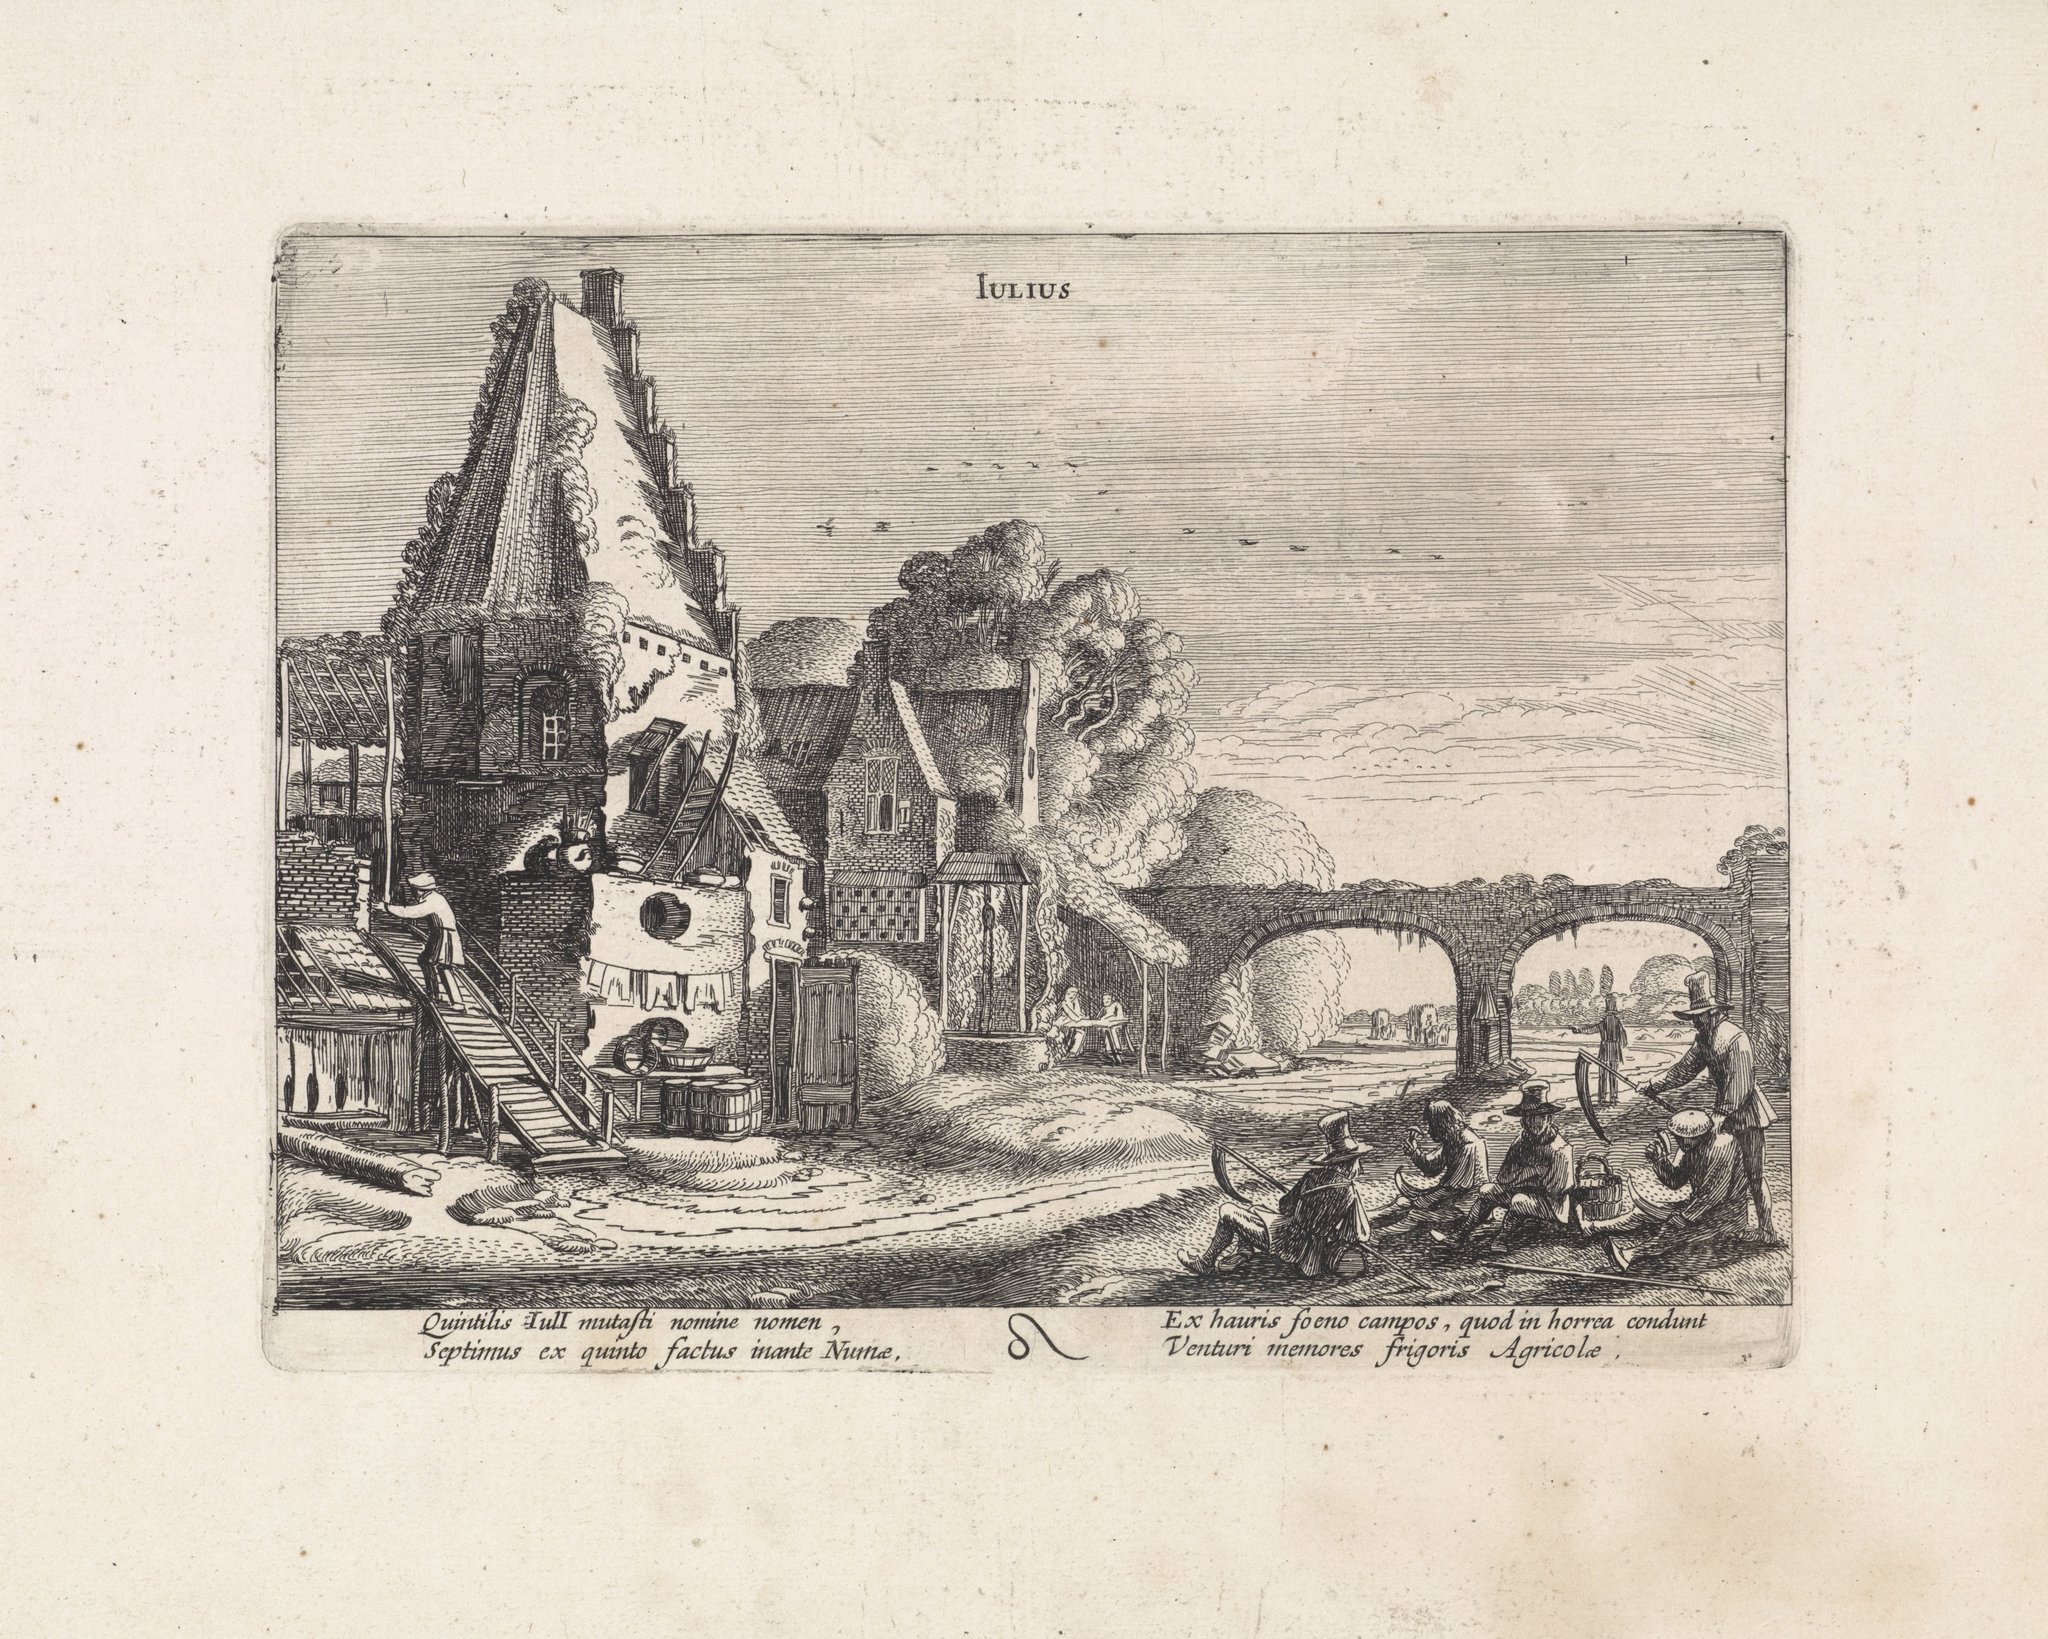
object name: print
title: Duodecim anni mensium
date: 1608-1618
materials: paper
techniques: etching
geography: northern netherlands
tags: agricultural implements: scythe, landscape with bridge, viaduct or aqueduct, leo (zodiacal sign of july), rest during harvest (eating, dancing, making love, etc.), tower (of house or building), landscape symbolizing july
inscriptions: collector's mark: Lugt 964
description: Gezicht op een huis en een aqauduct, waarvoor rustende maaiers met hun zeisen, voorstellende de maand juli. In het midden twee figuren aan een tafel bij een waterput. Onderaan het astrologische symbool van het sterrenbeeld leeuw. Prent uit een serie van twaalf.